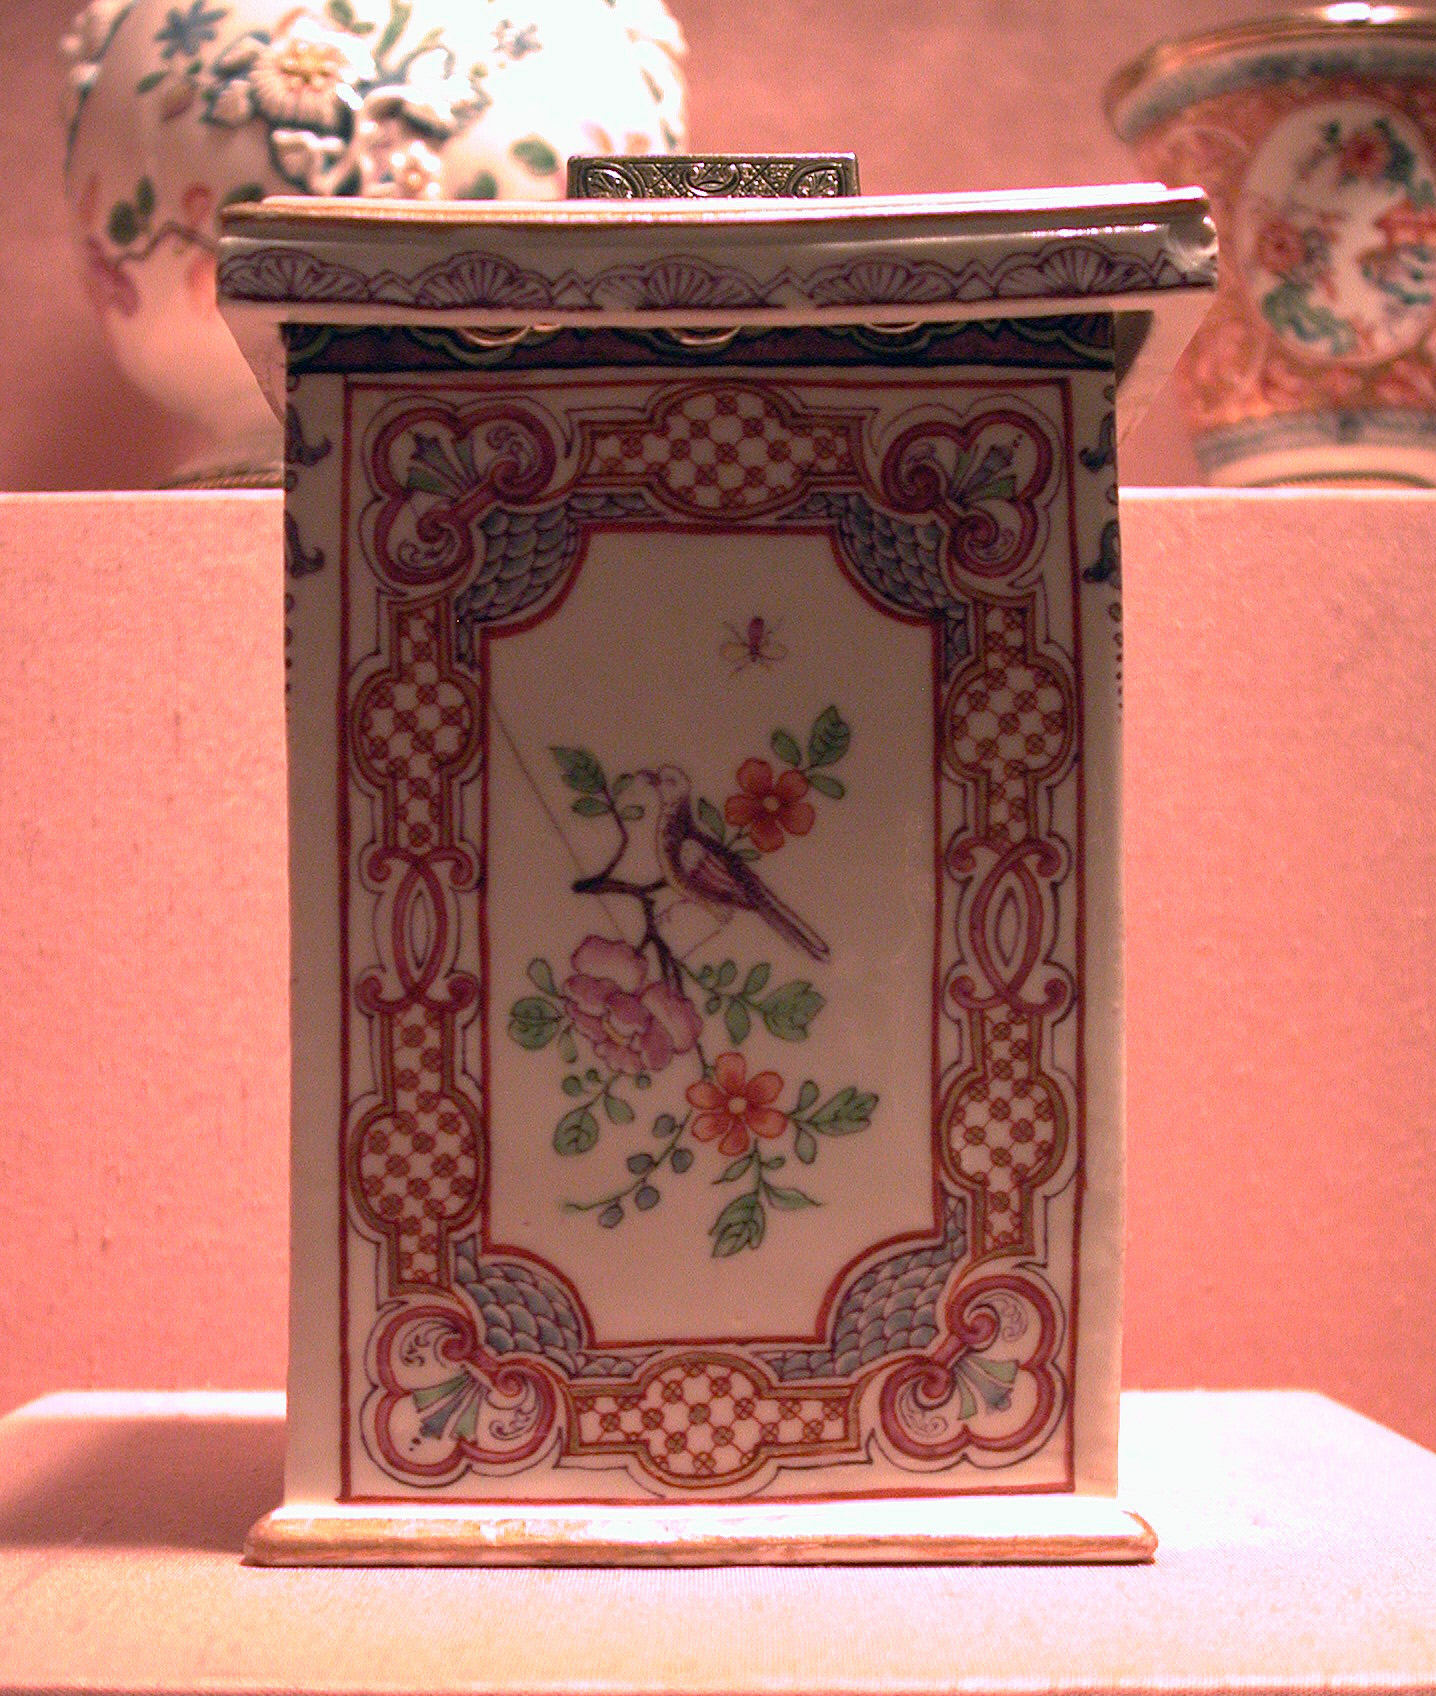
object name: tobacco box with cover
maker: vienna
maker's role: manufactory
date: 1730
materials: hard paste porcelain, silver gilt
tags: birds,flowers